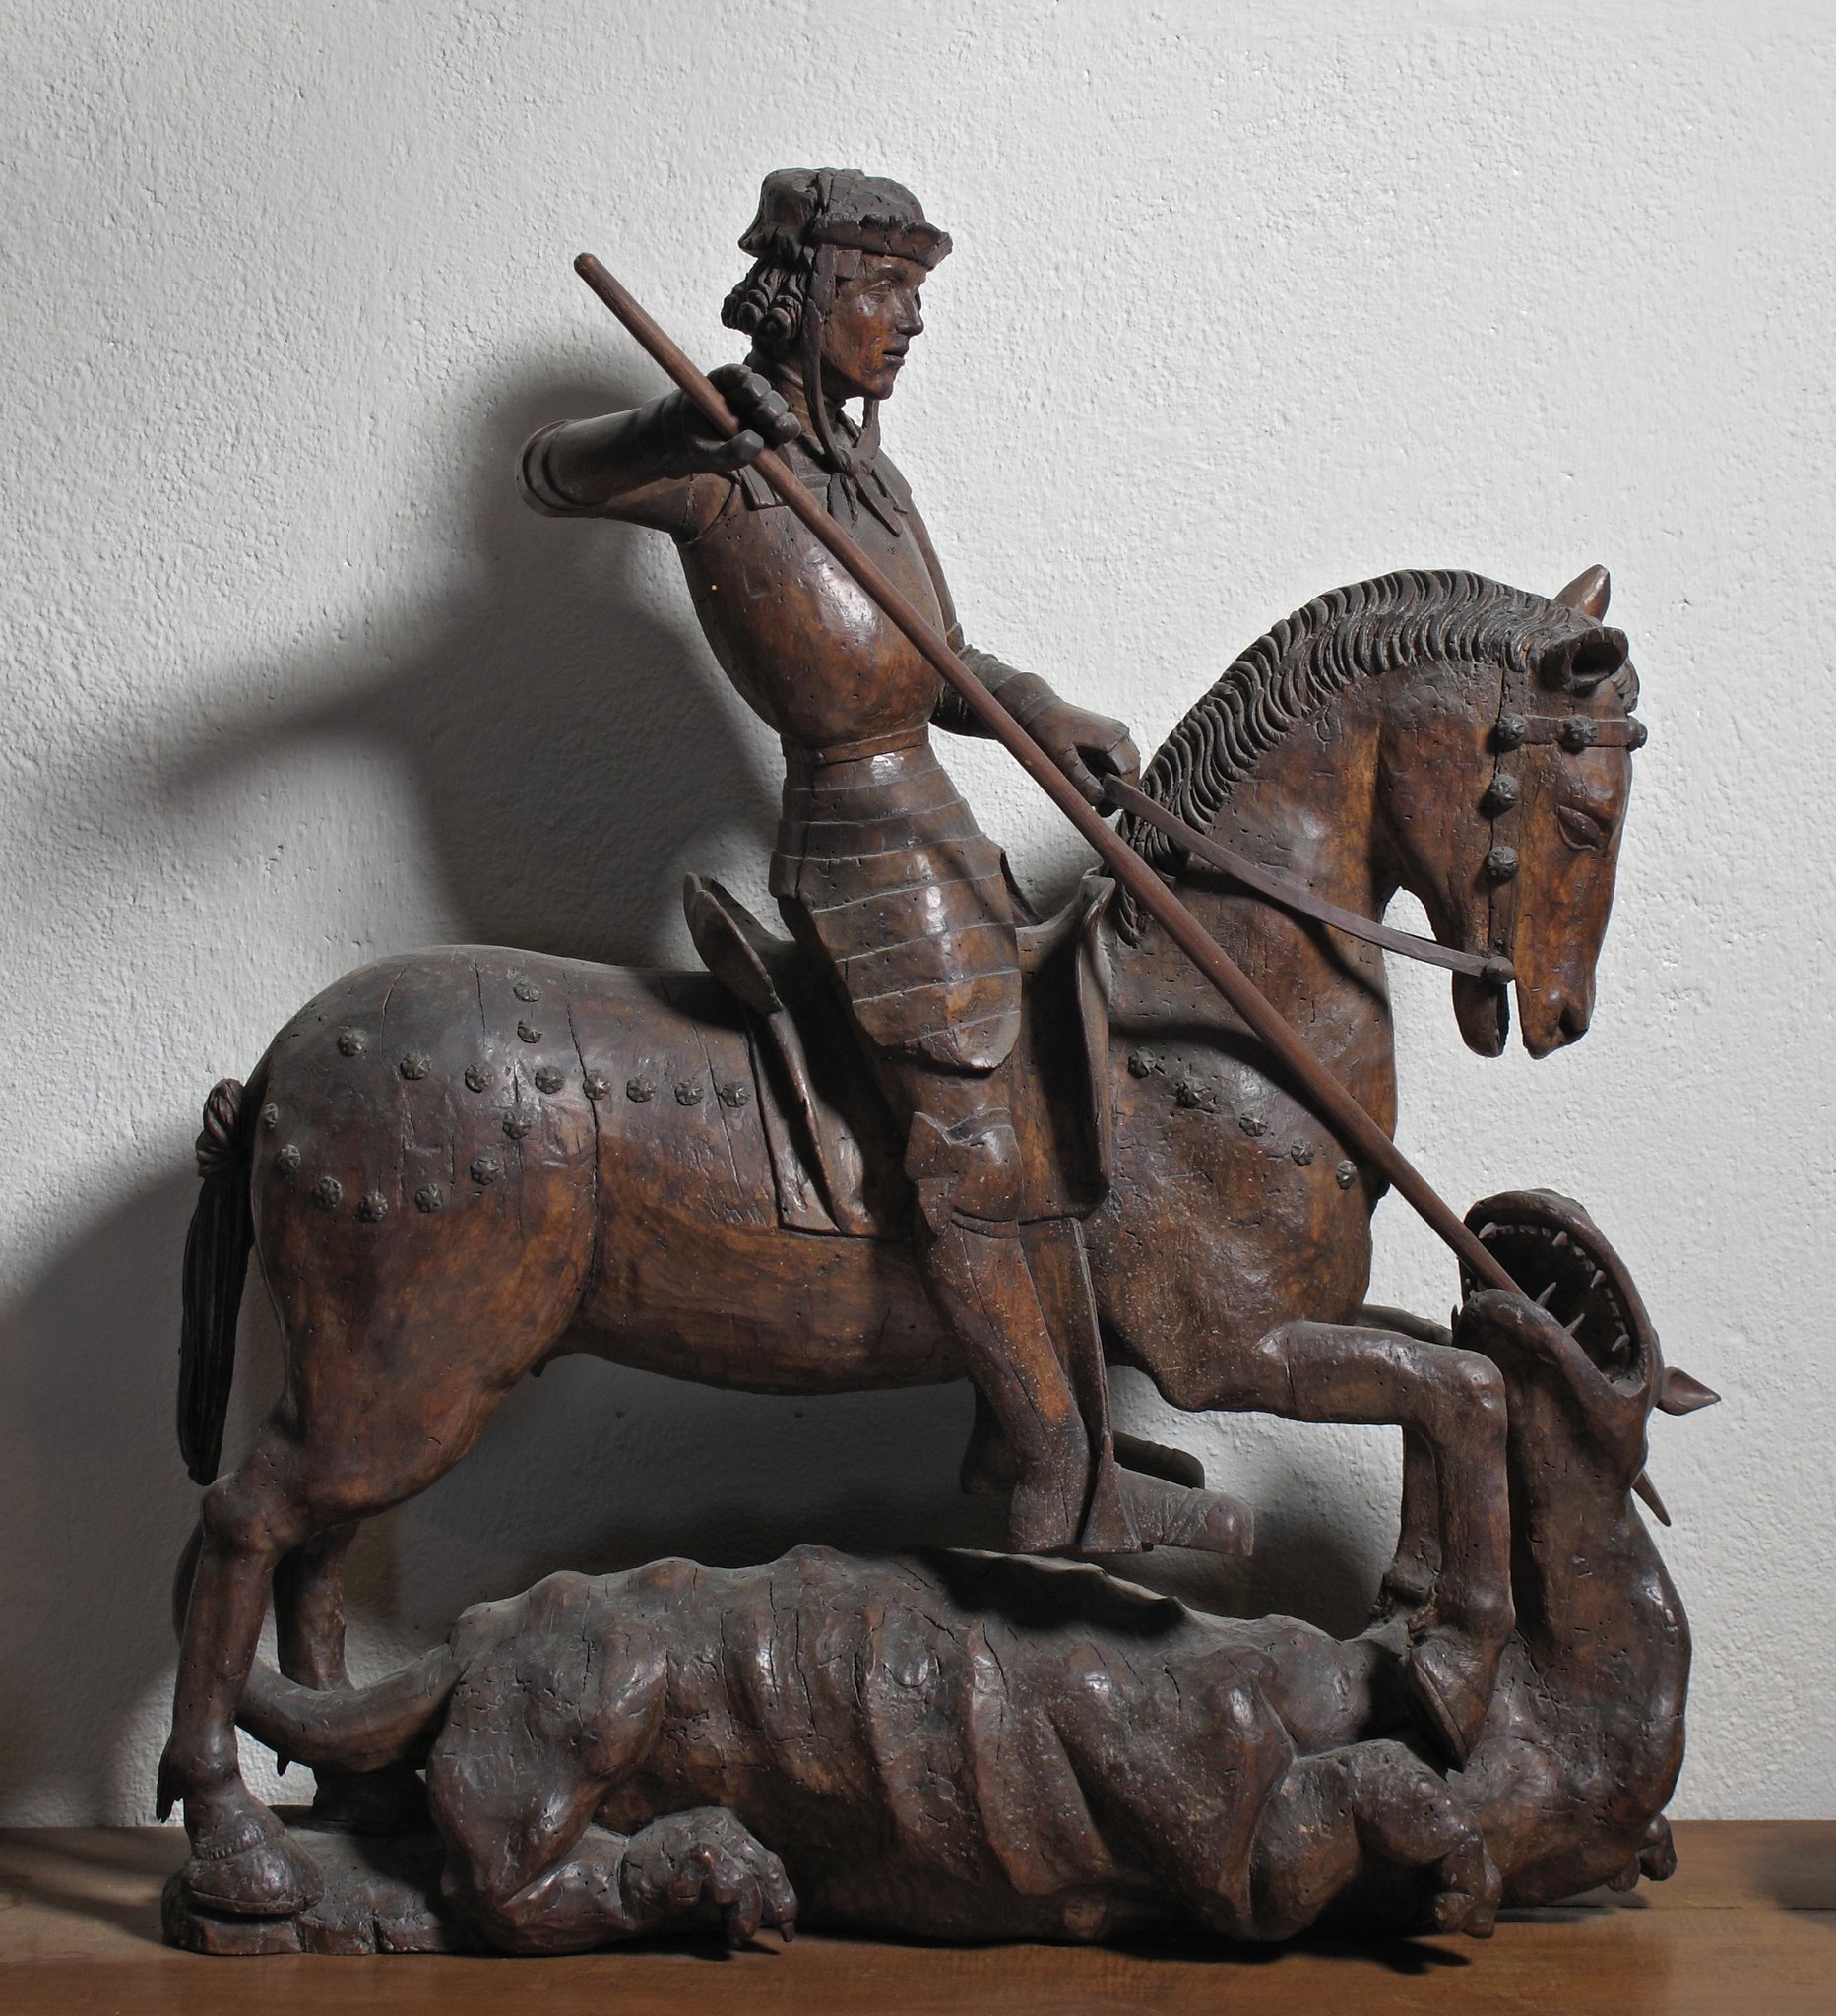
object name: statuette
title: Saint George and the Dragon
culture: french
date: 1501-1533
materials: wood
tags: dragons,saint george